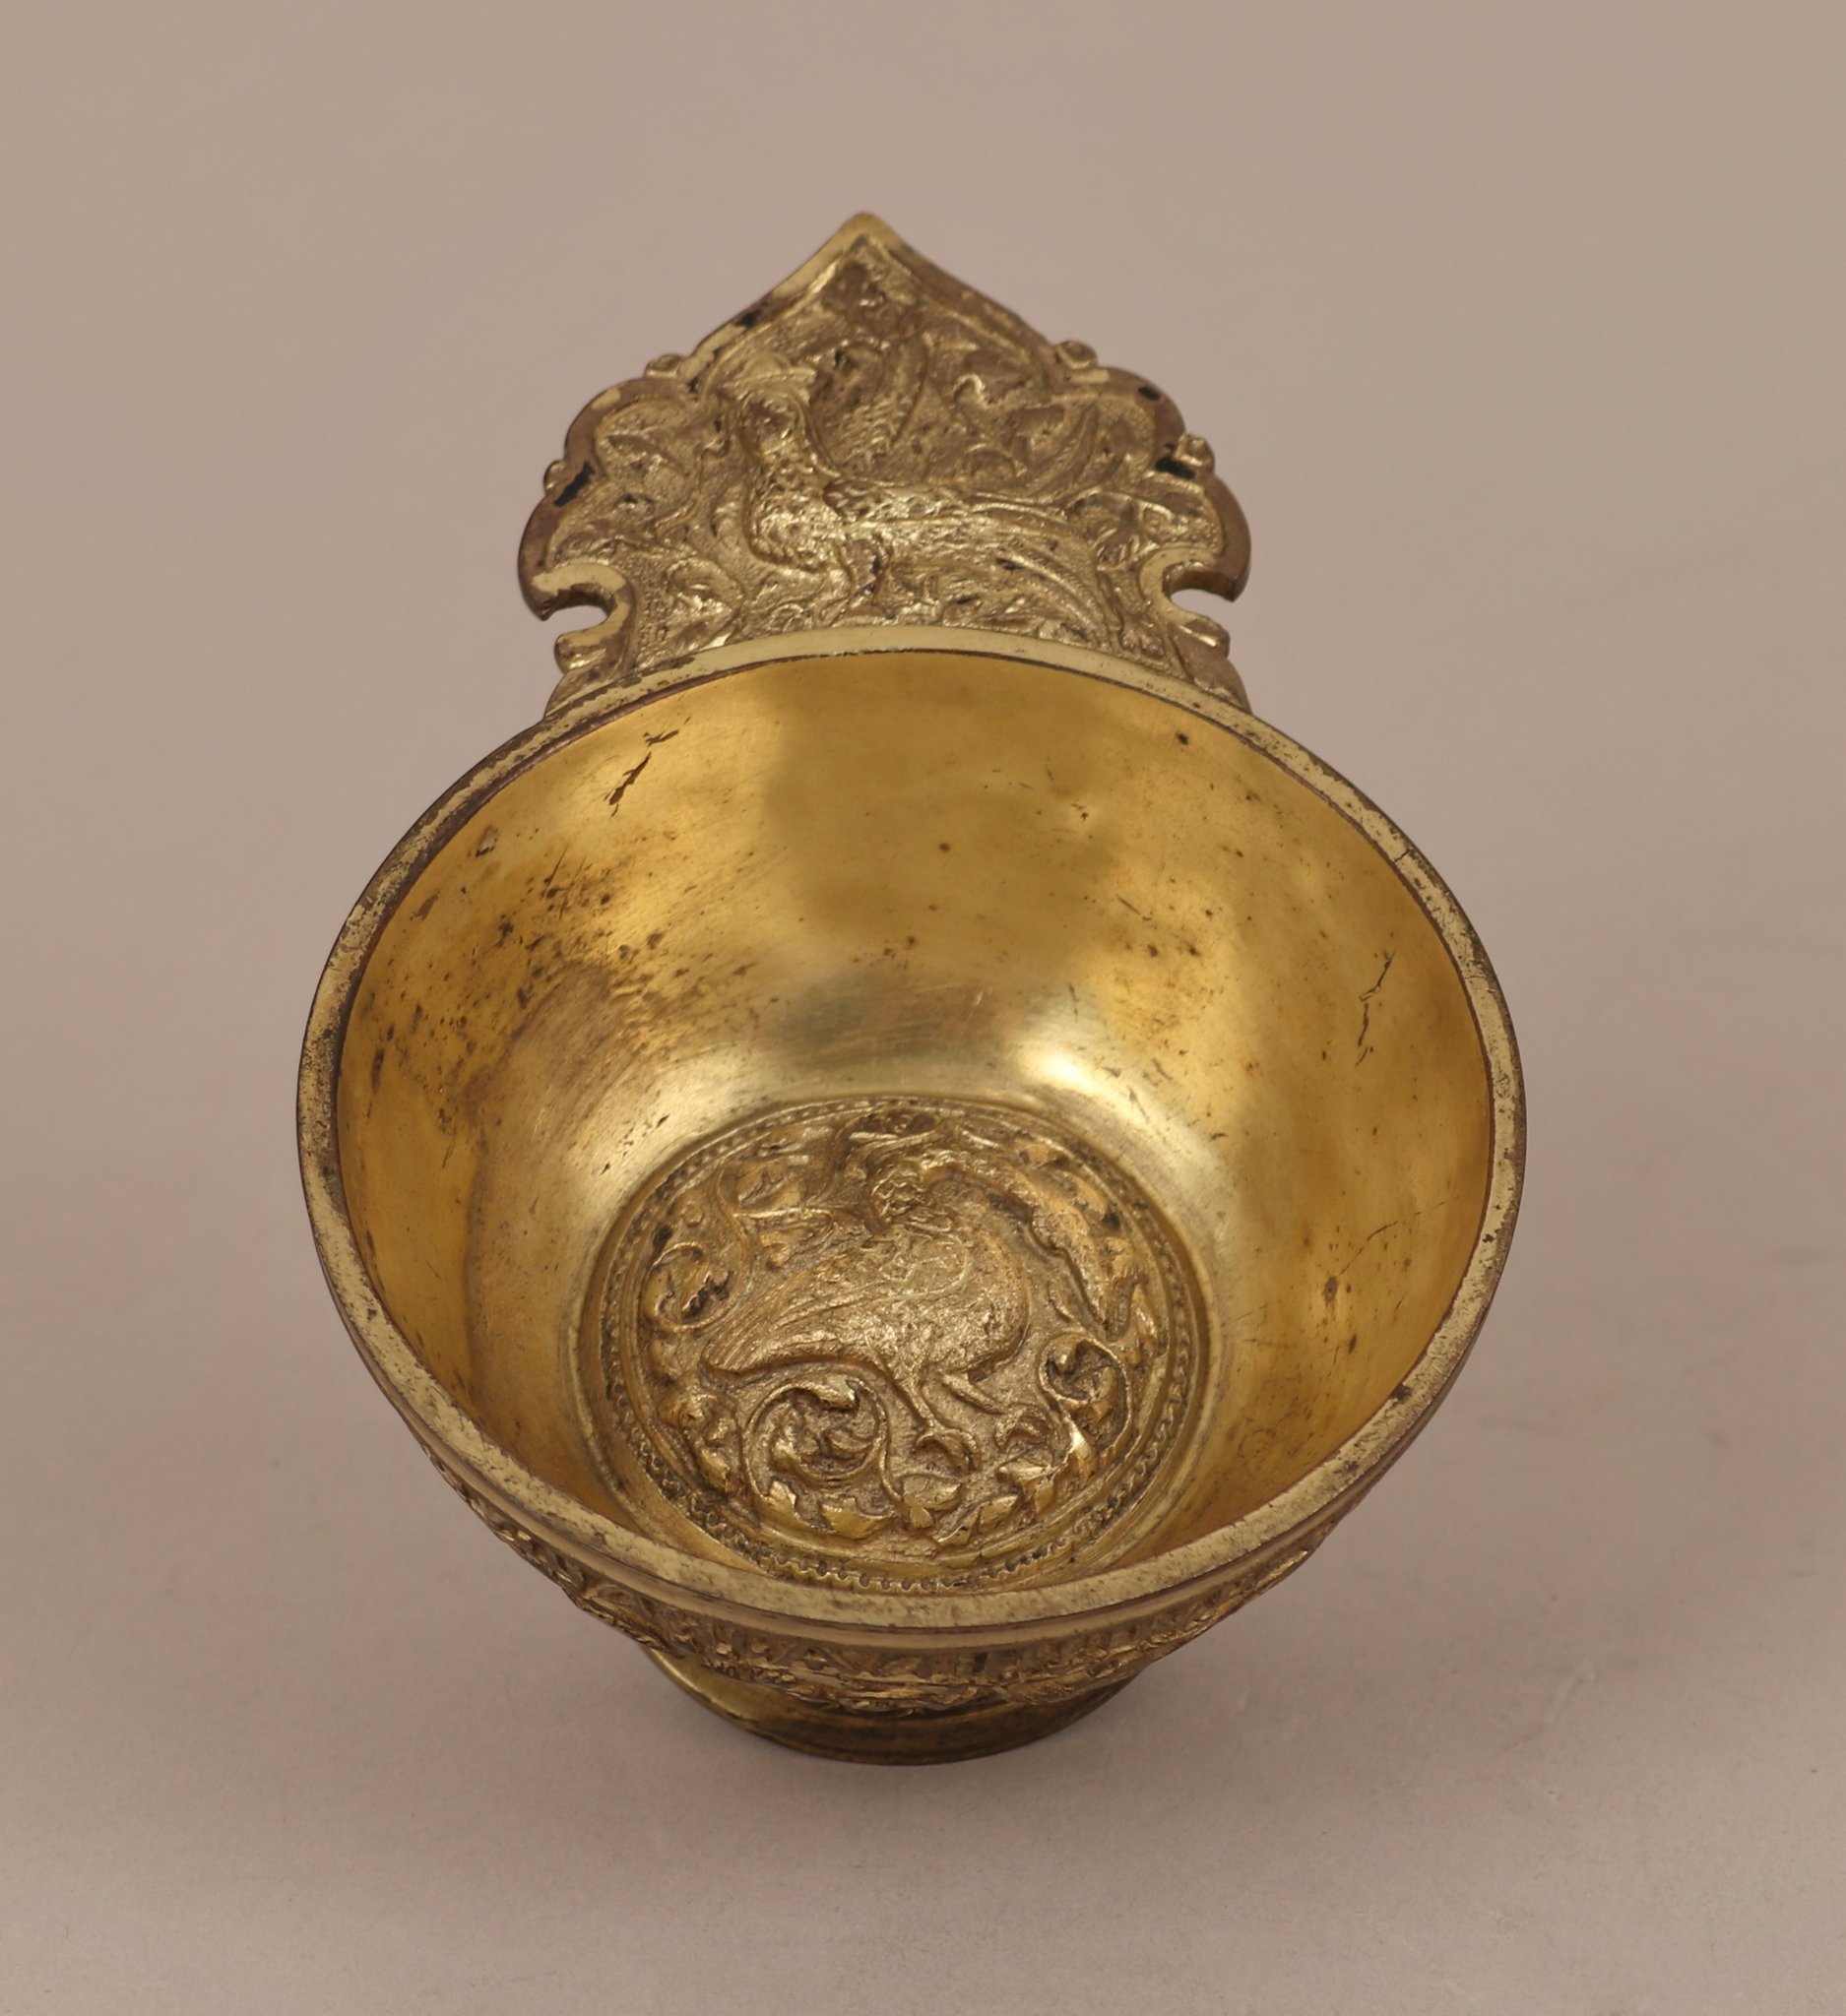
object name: cup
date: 1801-1900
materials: metal, silver